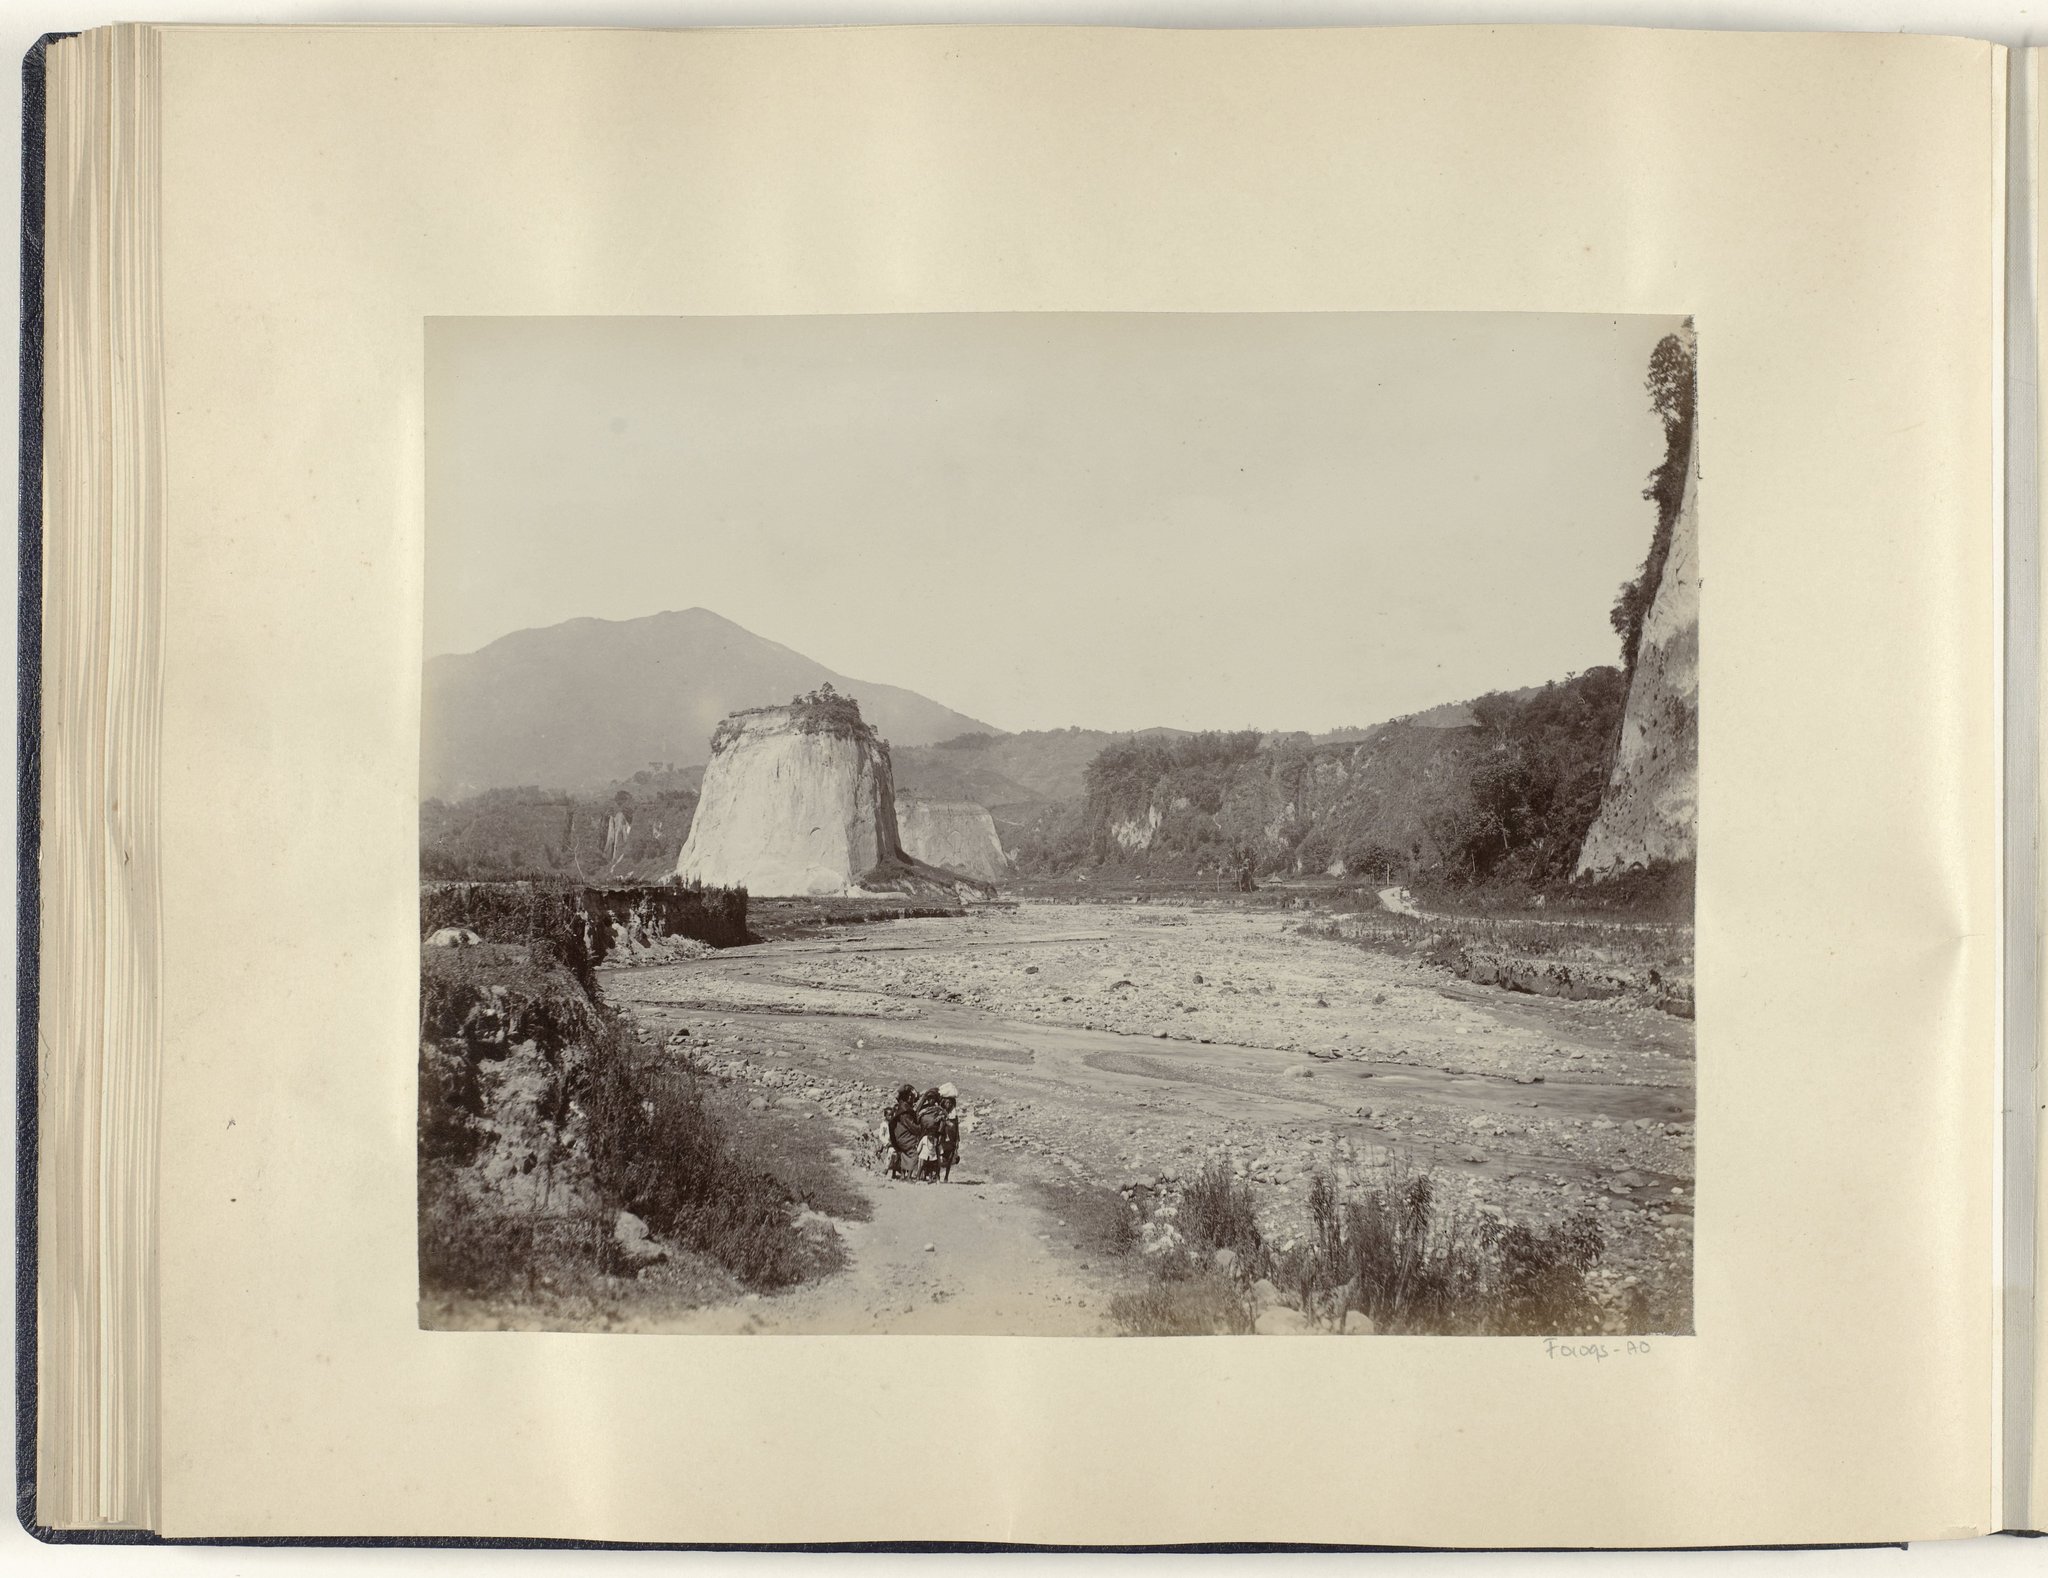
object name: photograph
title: Vrouwen en kinderen bij een drooggevallen rivierbedding in een uitgesleten landschap, mogelijk op Sumatra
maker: Anonymous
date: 1895-1905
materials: paper, photographic support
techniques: albumen print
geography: sumatra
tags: dry river, river bed, sumatra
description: Onderdeel van Reisalbum met foto's van bezienswaardigheden in Italië, Zwitserland en Nederlands-Indië.